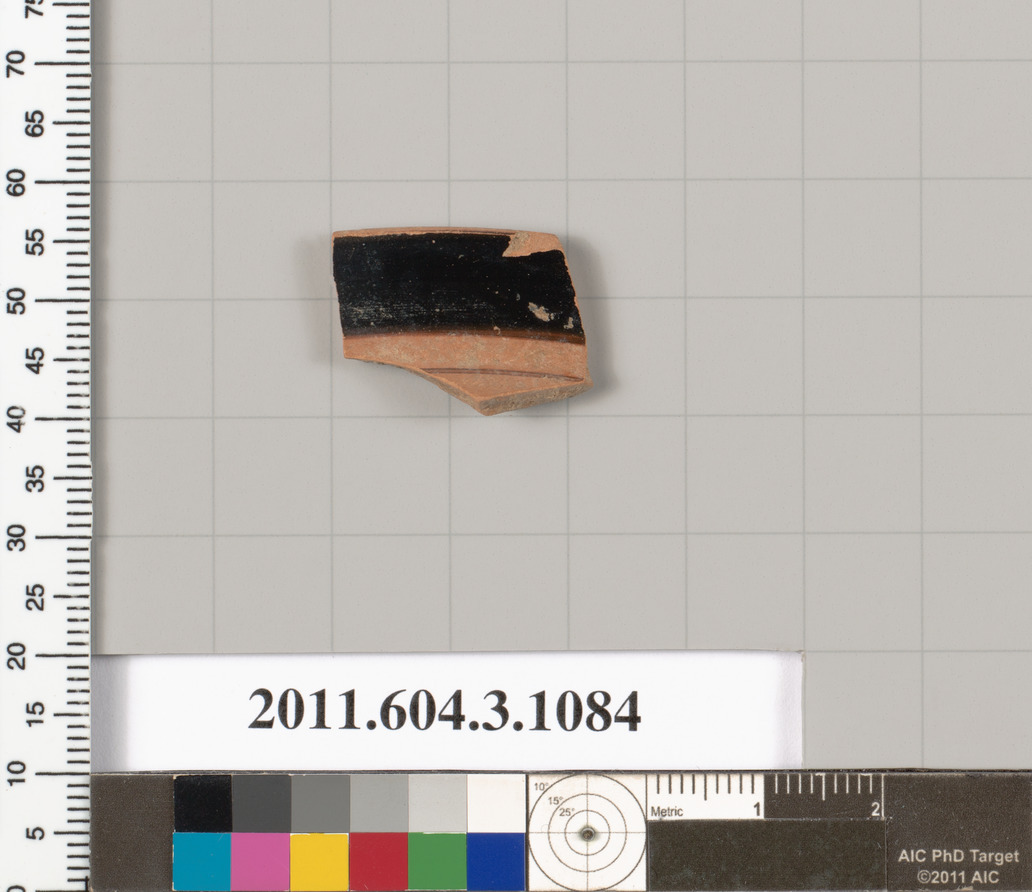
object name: mastoid fragment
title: Terracotta rim fragment of a mastoid (drinking cup with narrow base)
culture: greek, attic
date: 534-468 BCE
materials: terracotta